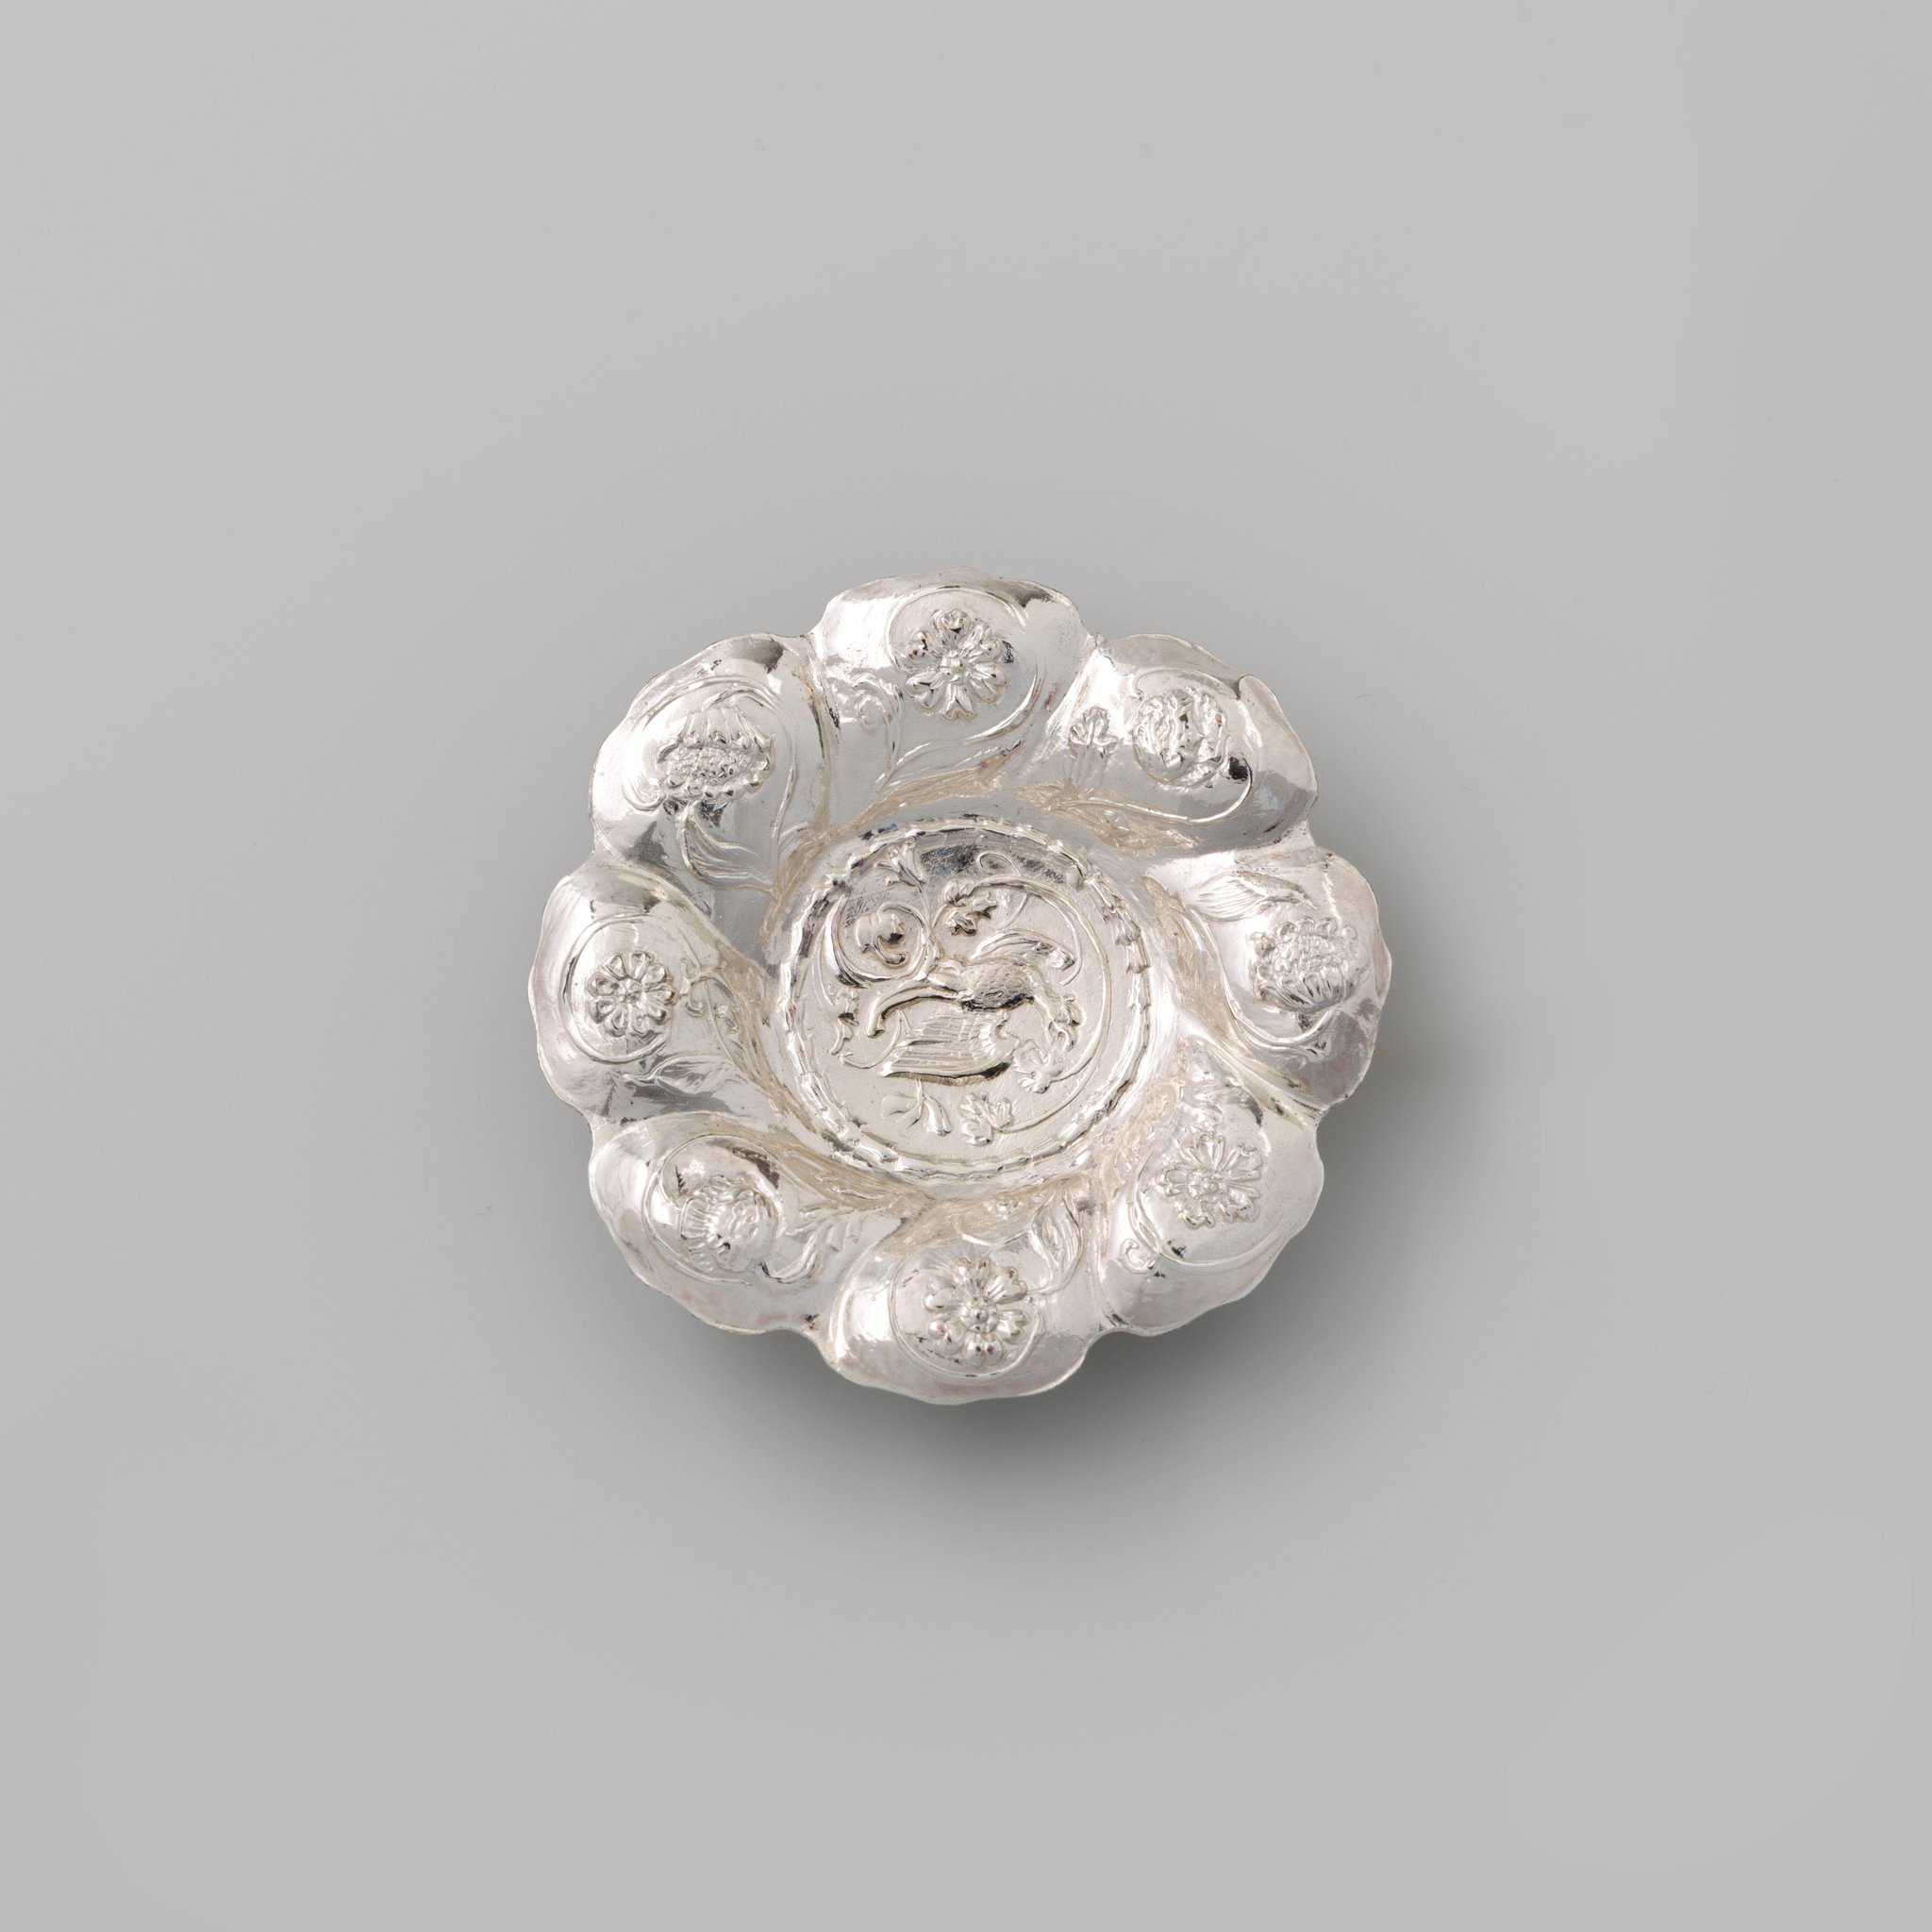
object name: miniature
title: Fruitschotel, geplooid, van zilver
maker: Anonymous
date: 1675-1700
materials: silver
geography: amsterdam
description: Plooischotel van zilver met acht lobben met gedreven bloemmotief; op de bodem een vogel omringd door bloemenranken.